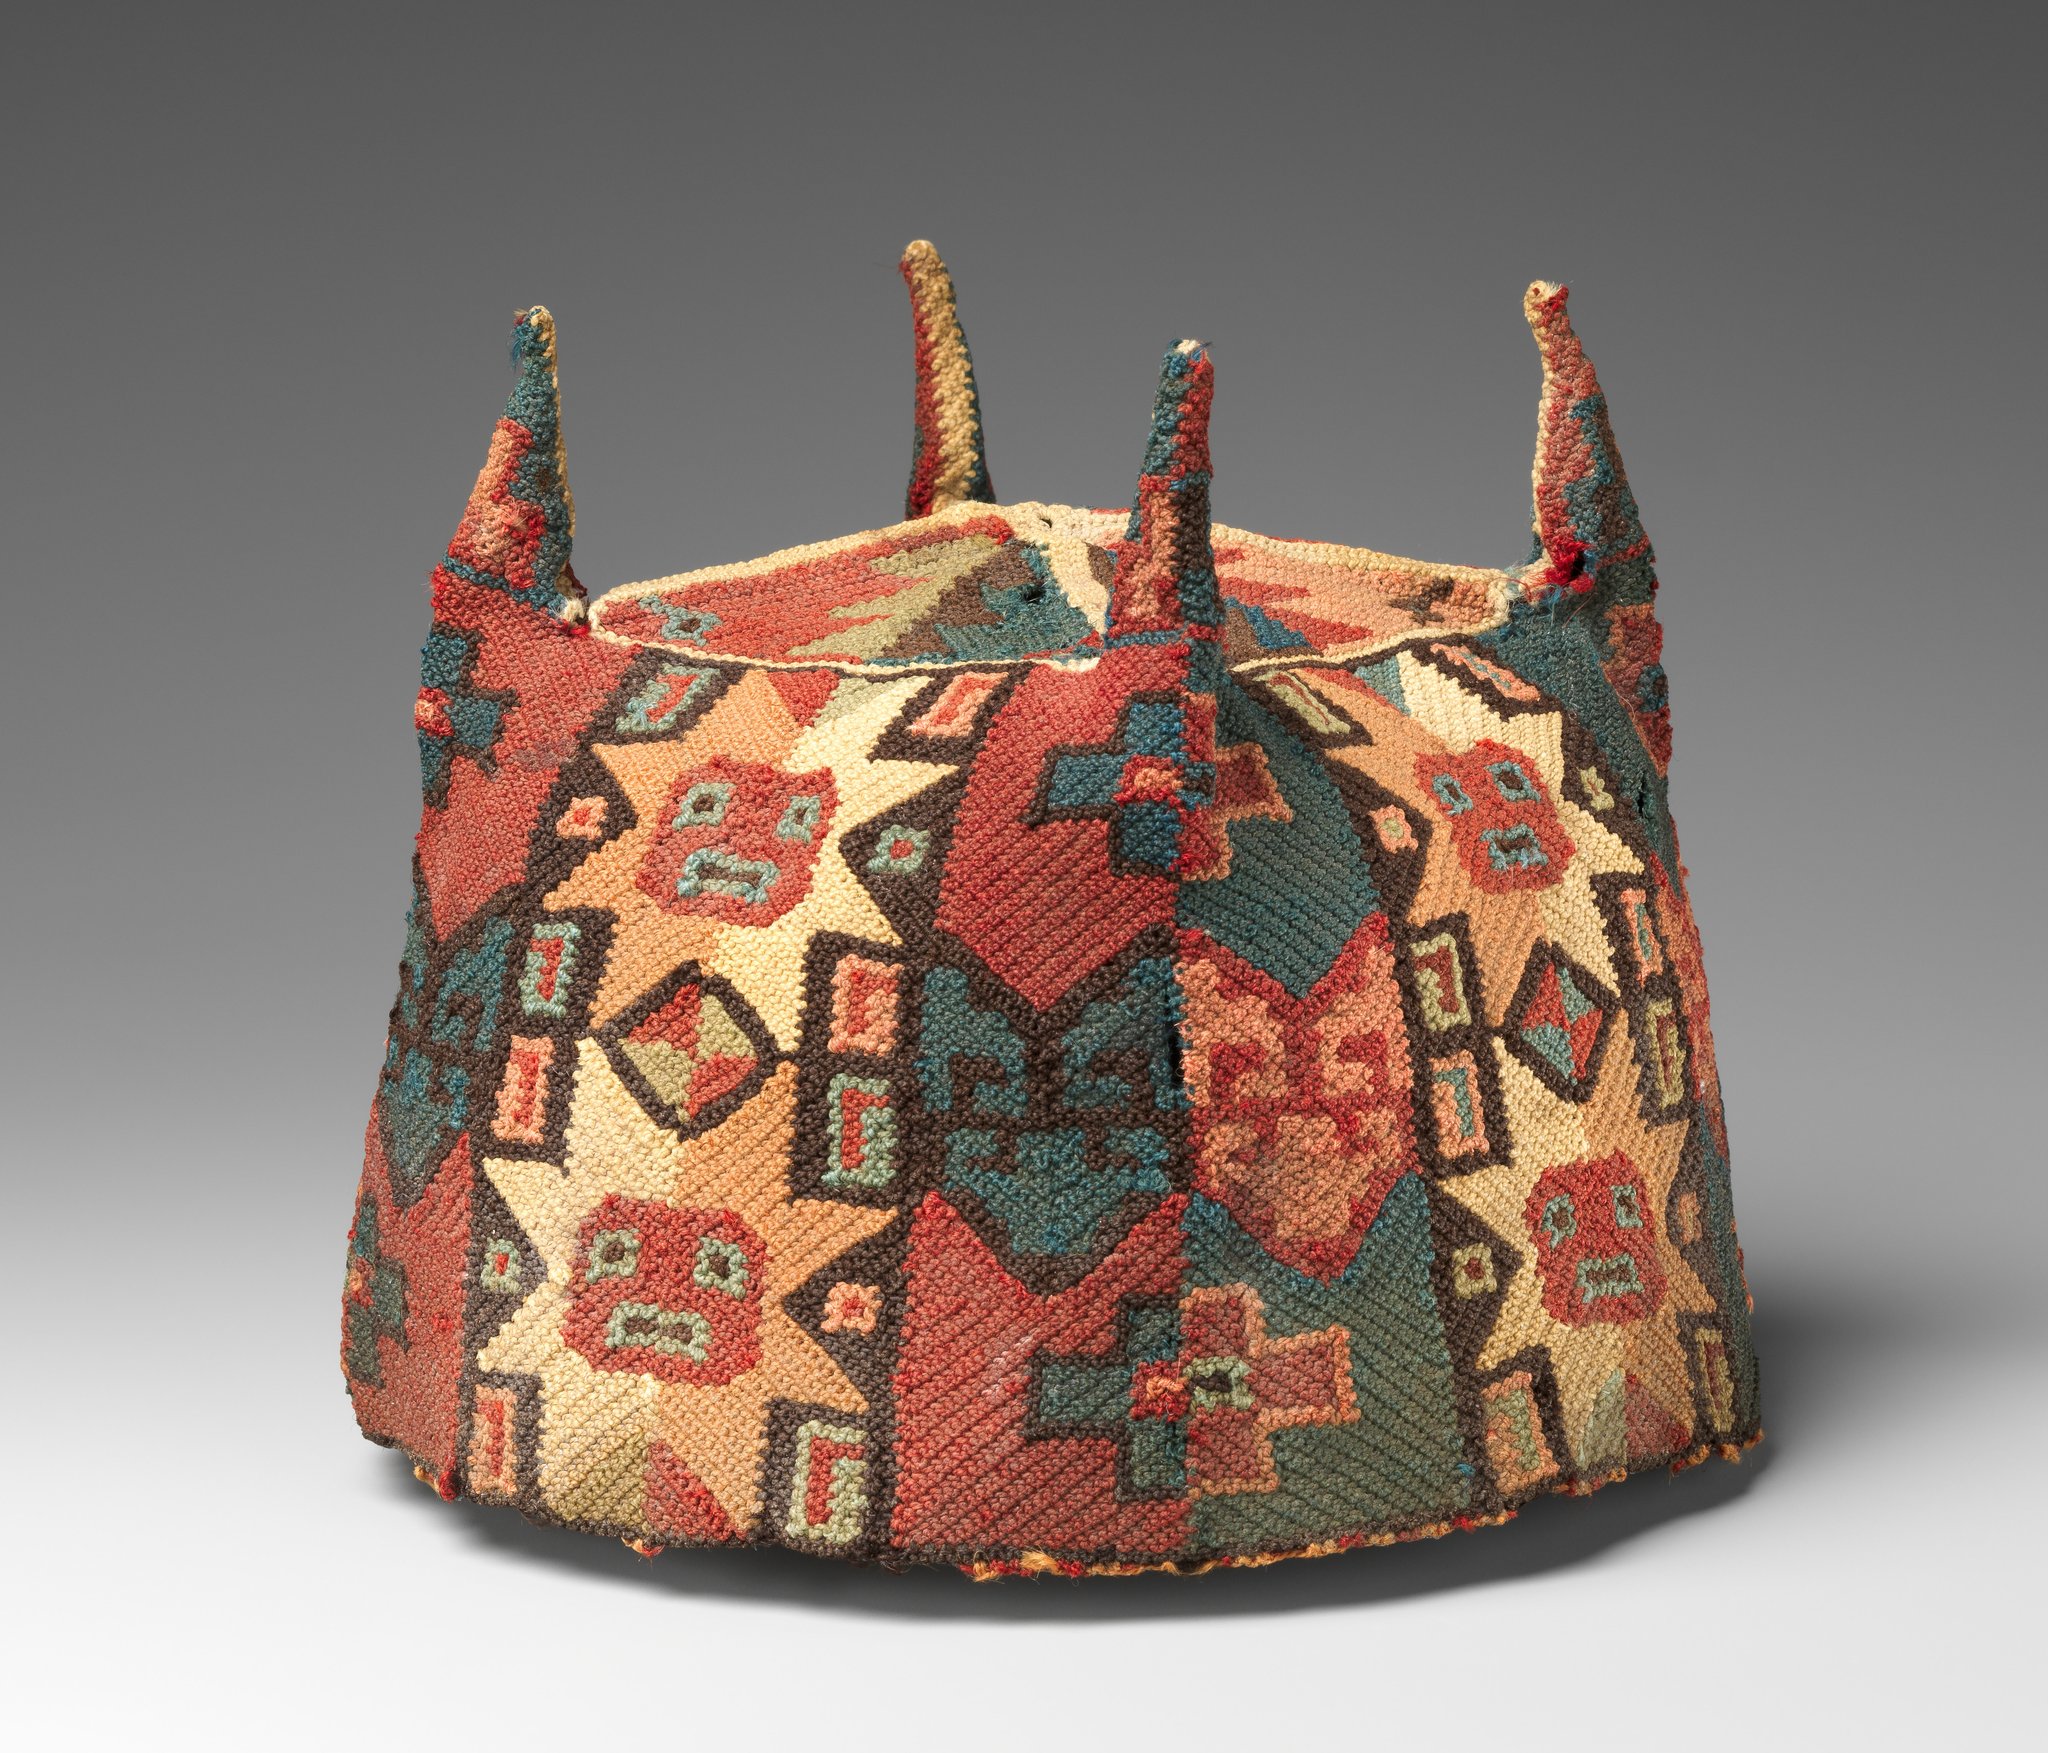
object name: hat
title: Four-Cornered Hat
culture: tiwanaku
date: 401-900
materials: animal fiber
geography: peru or bolivia